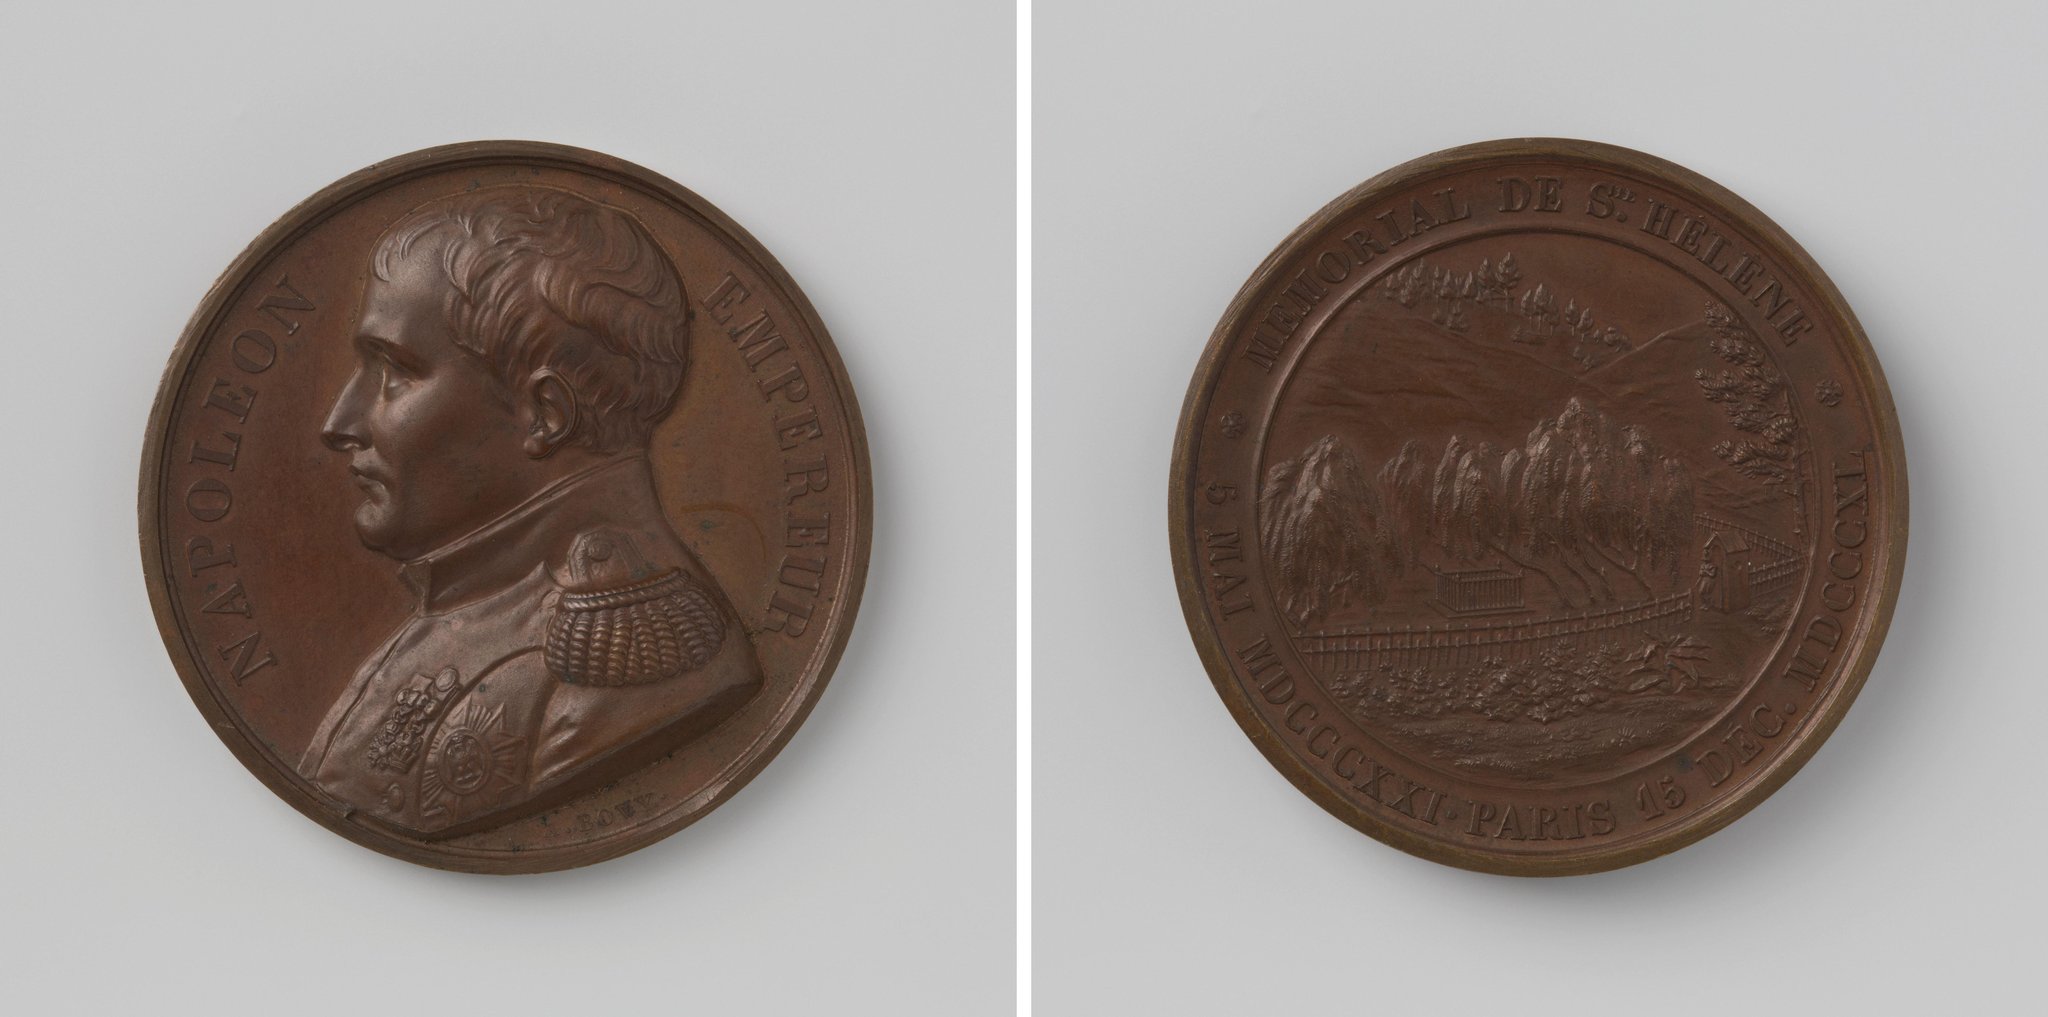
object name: history medal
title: Overbrenging van het lijk van Napoleon Bonaparte van St. Helena naar Frankrijk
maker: jean françois antoine bovy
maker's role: medailleur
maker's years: 1795-1877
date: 1840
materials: bronze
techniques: striking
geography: paris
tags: napoleon i (emperor of the french), paris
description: Bronzen penning. Voorzijde: borststuk man binnen omschrift. Keerzijde: landschap binnen omschrift